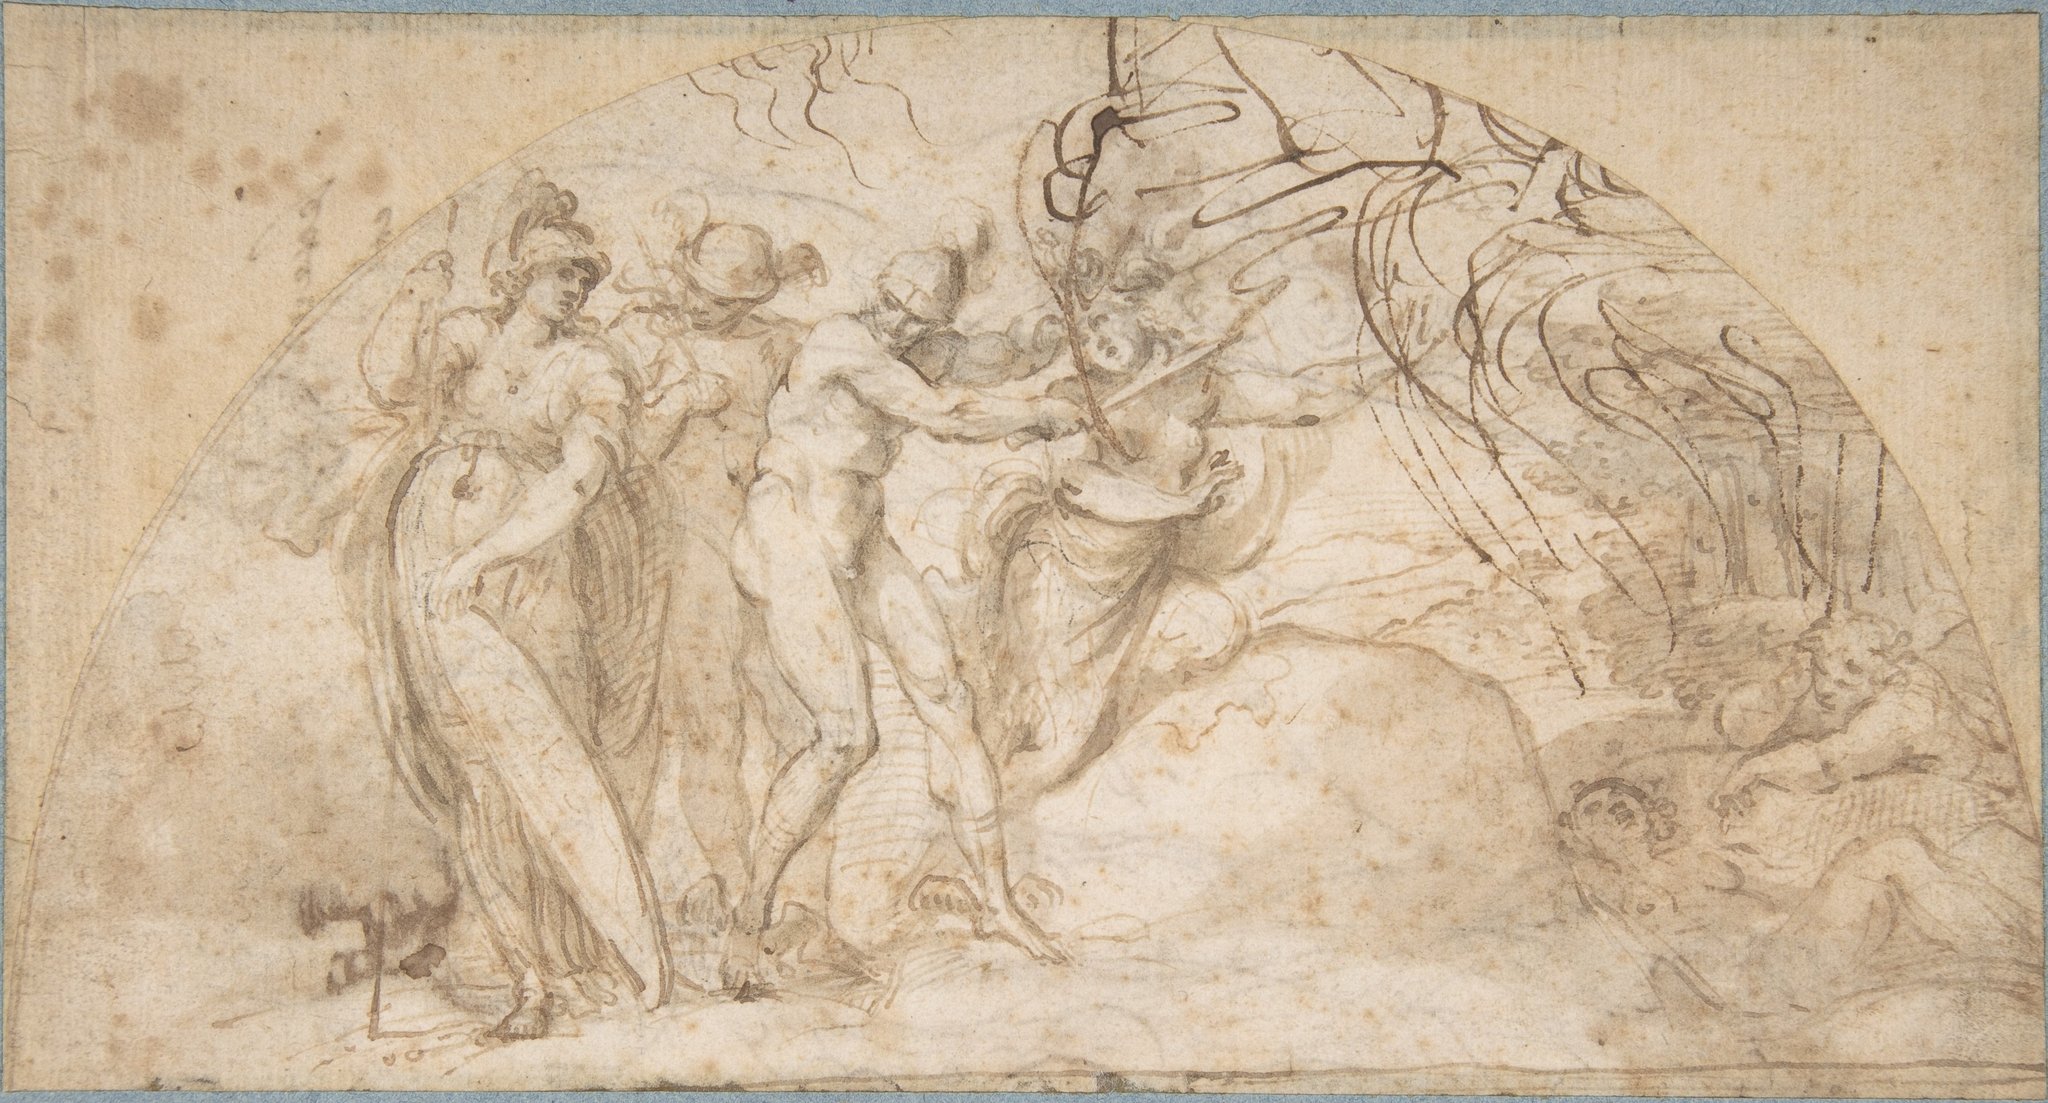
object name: drawing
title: Perseus Beheading Medusa (recto); Studies of a Child and Ornament Sketches (verso)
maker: annibale carracci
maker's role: artist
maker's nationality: italian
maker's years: 1560-1609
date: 1560-1609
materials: chalk, charcoal, ink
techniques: brush, pen, wash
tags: ornament,children,medusa,perseus